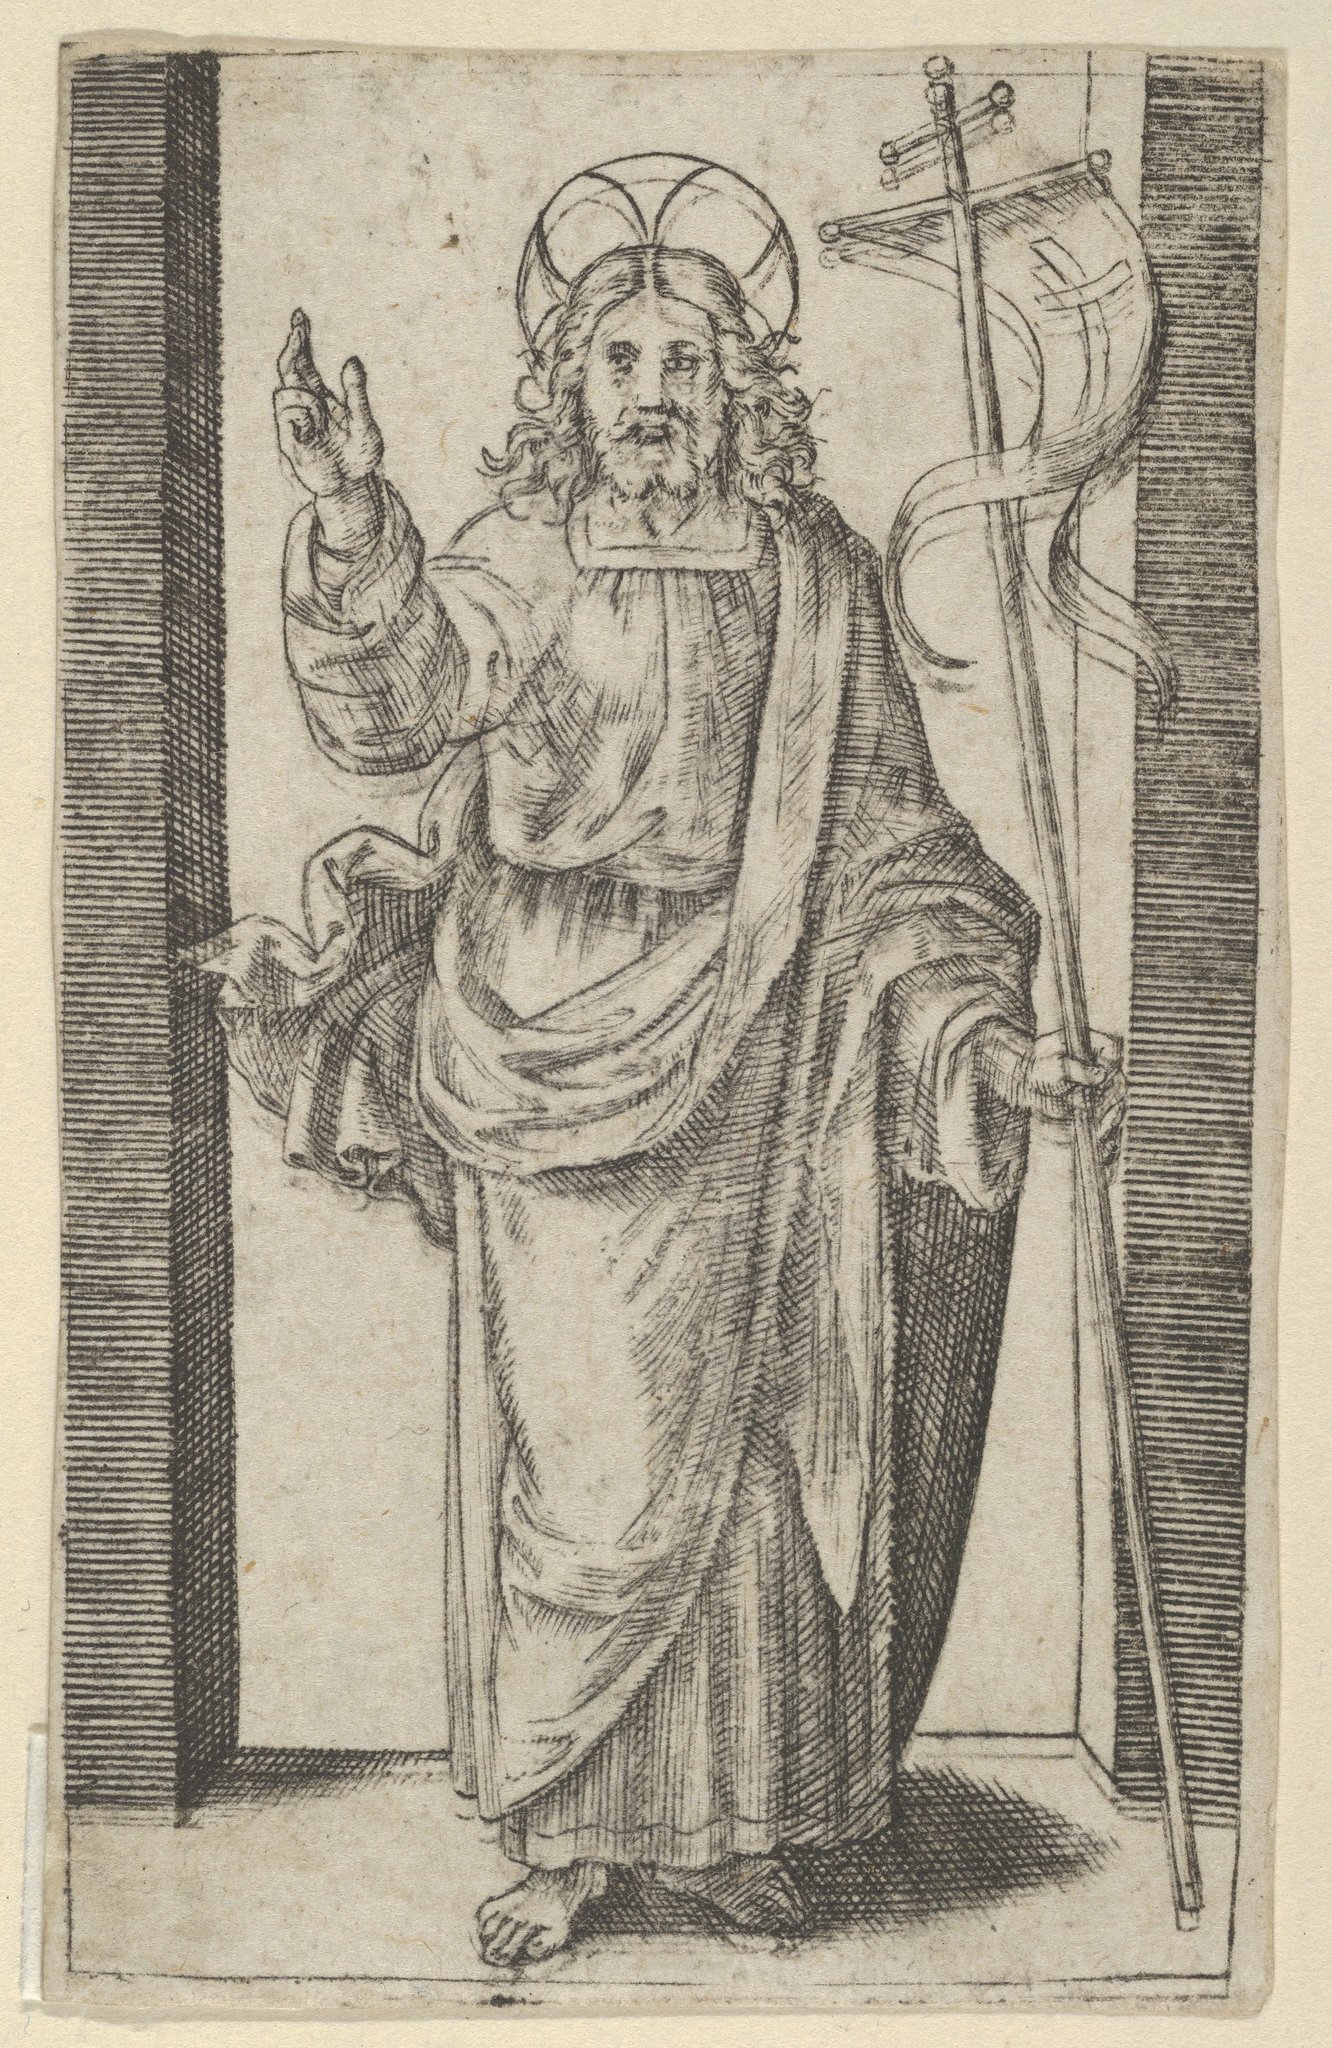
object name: print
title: Christ, right hand raised in the gesture of blessing, from "Piccoli Santi" (Small Saints)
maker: marcantonio raimondi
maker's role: artist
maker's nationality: italian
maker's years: 1475-1534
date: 1500-1527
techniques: engraving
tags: christ